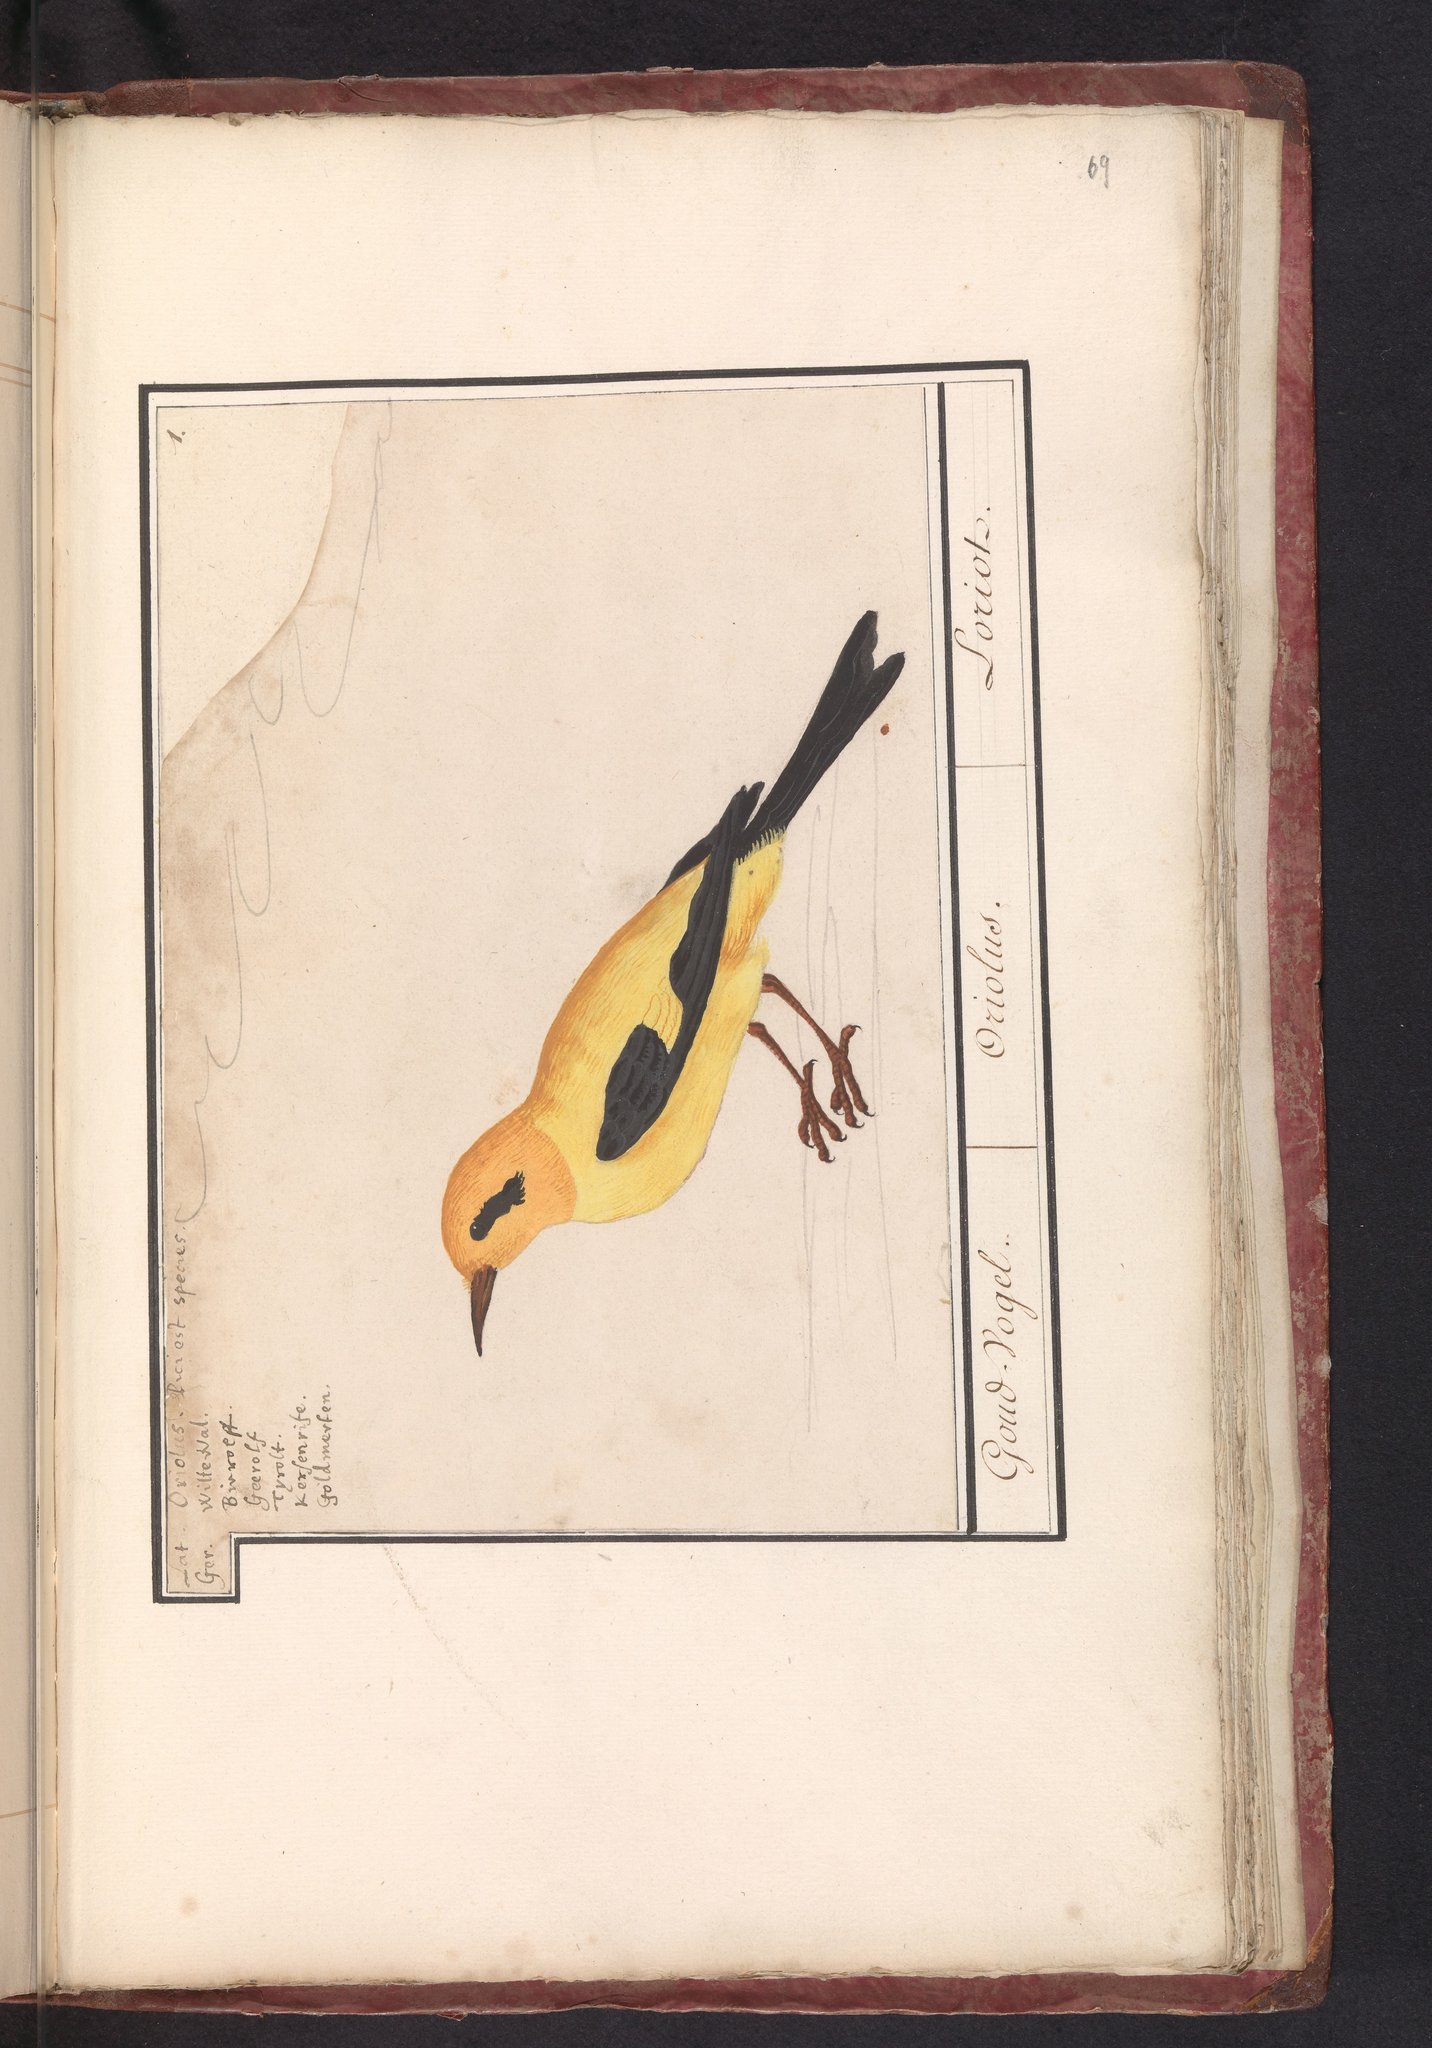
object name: drawing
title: Goud-Vogel. / Oriolus. / Loriot.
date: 1596-1610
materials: paint, ink, paper, pencil, watercolor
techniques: brush, pen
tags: song-birds: oriole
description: Wielewaal. Genummerd rechtsboven: 1. Linksboven de naam in zeven talen. Onderdeel van het eerste album met tekeningen van vogels. Derde van twaalf albums met tekeningen van dieren, vogels en planten bekend rond 1600, gemaakt in opdracht van keizer Rudolf II. Met toelichting in Nederlands, Latijn en Frans.